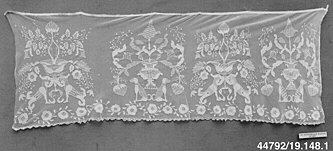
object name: valance fragment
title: Portion of a valance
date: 1801-1833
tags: animals,flowers